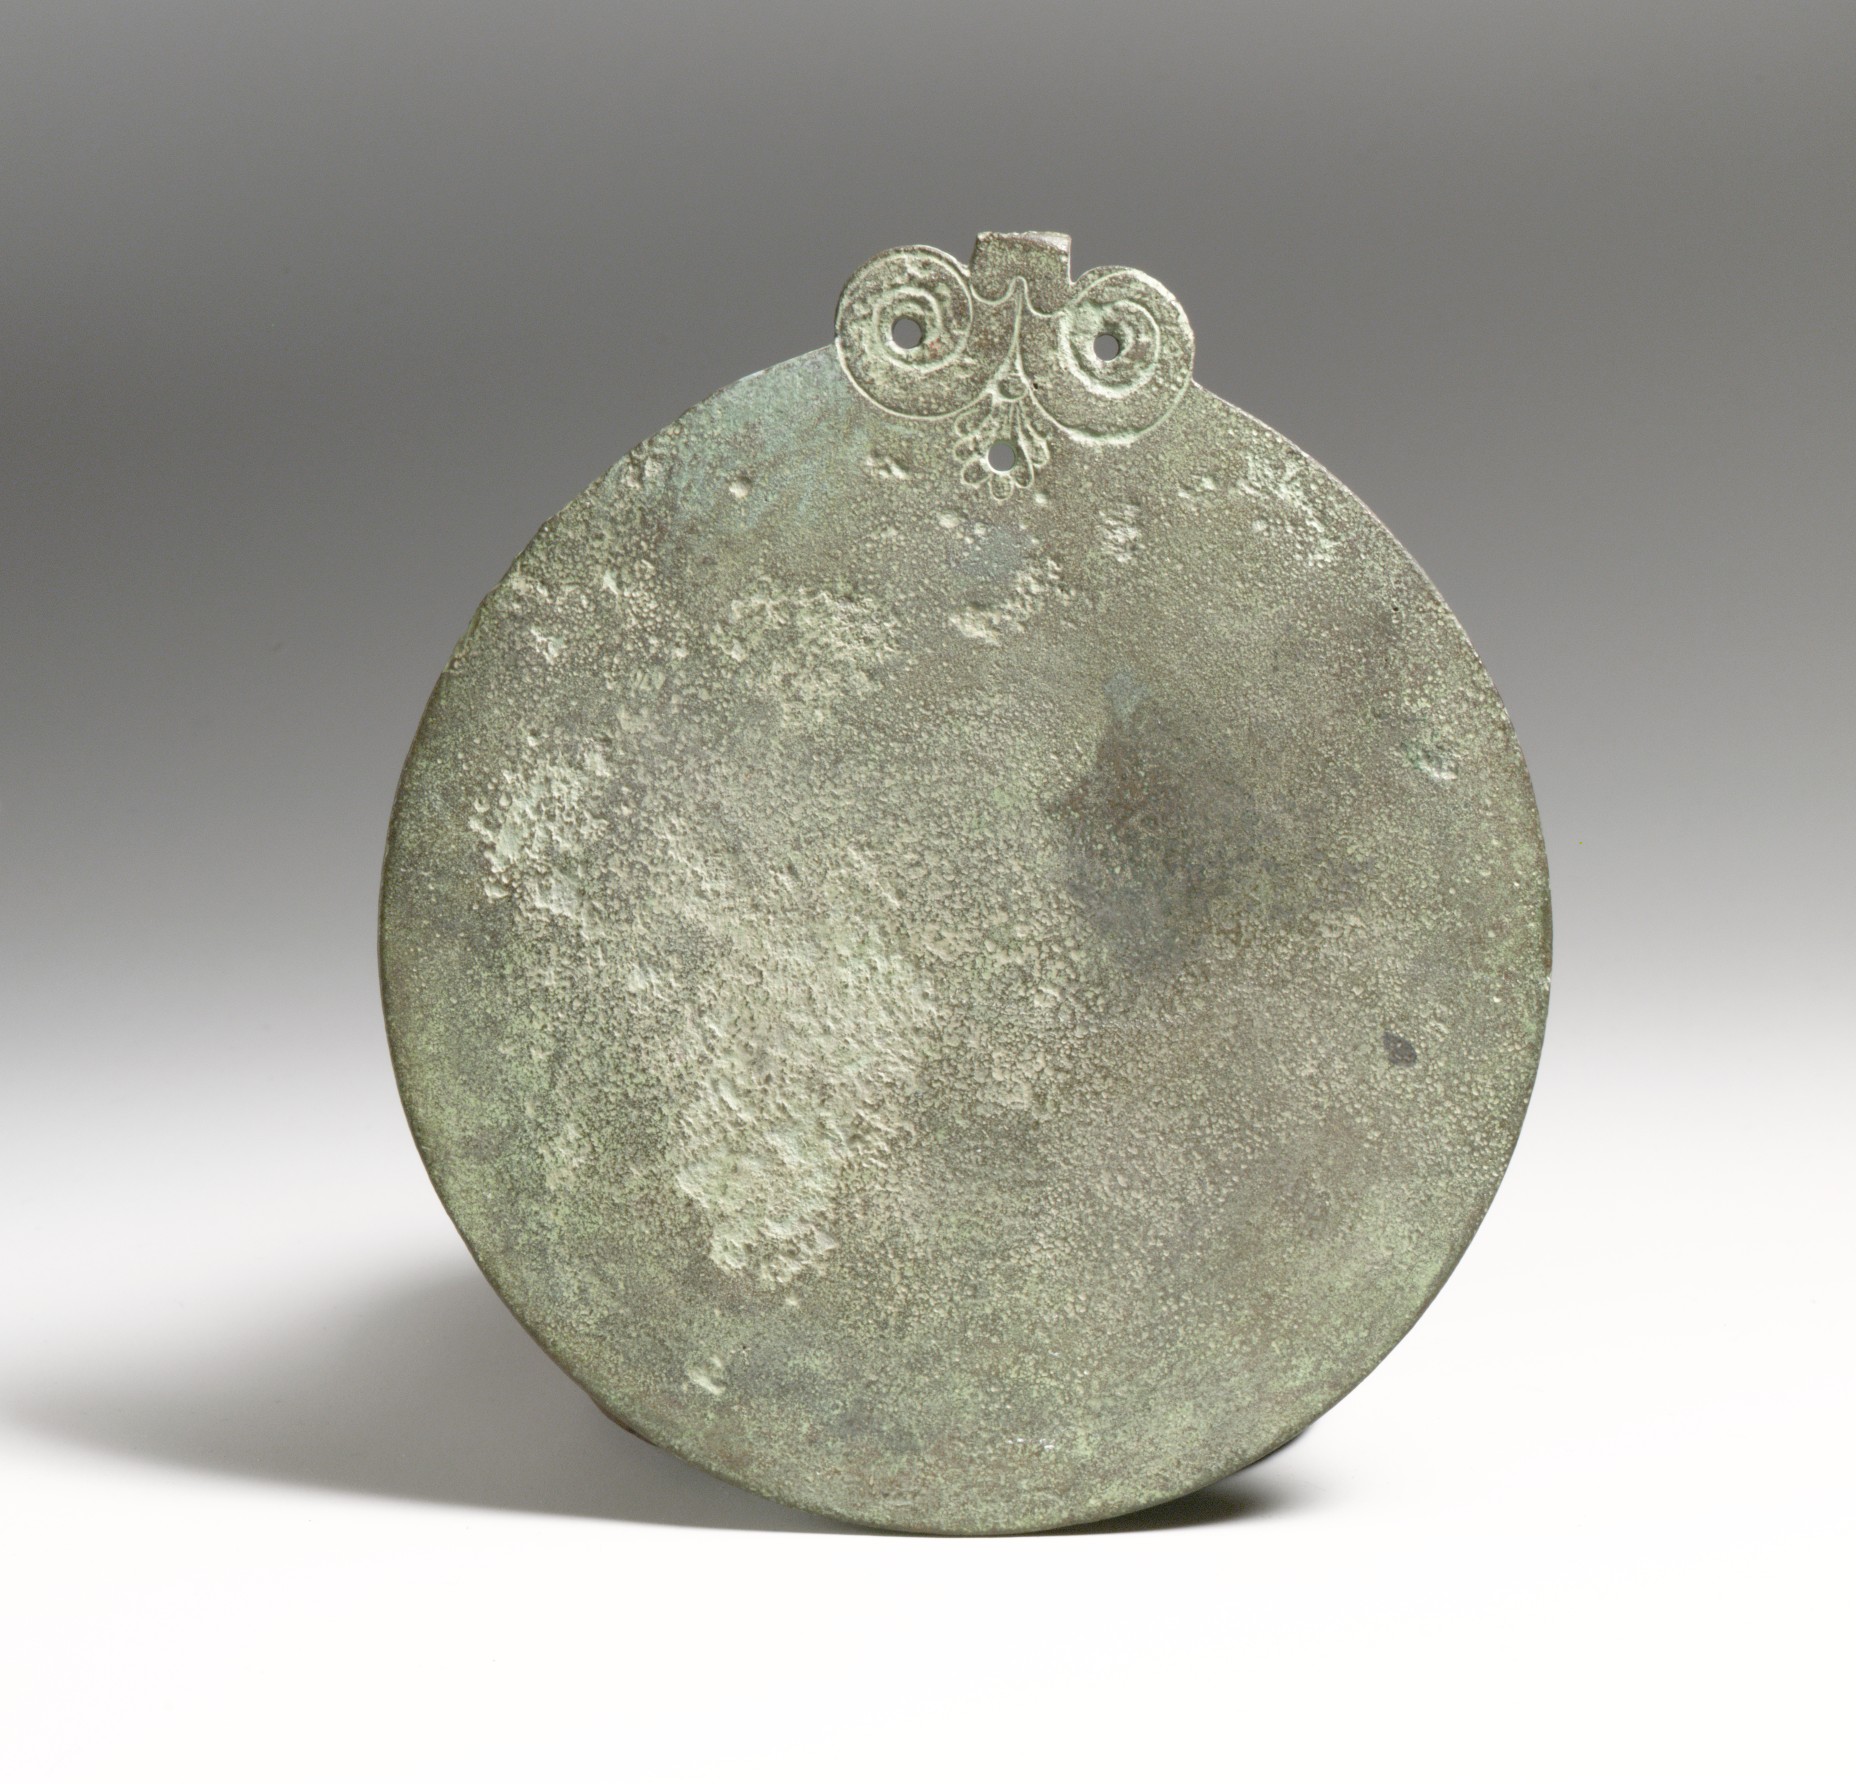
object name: mirror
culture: greek, cypriot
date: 7000-30 BCE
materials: bronze